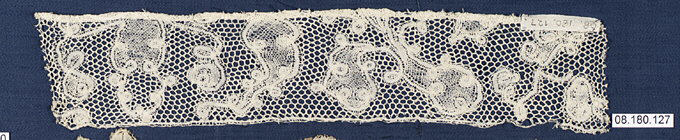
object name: fragment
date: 1601-1800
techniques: lace